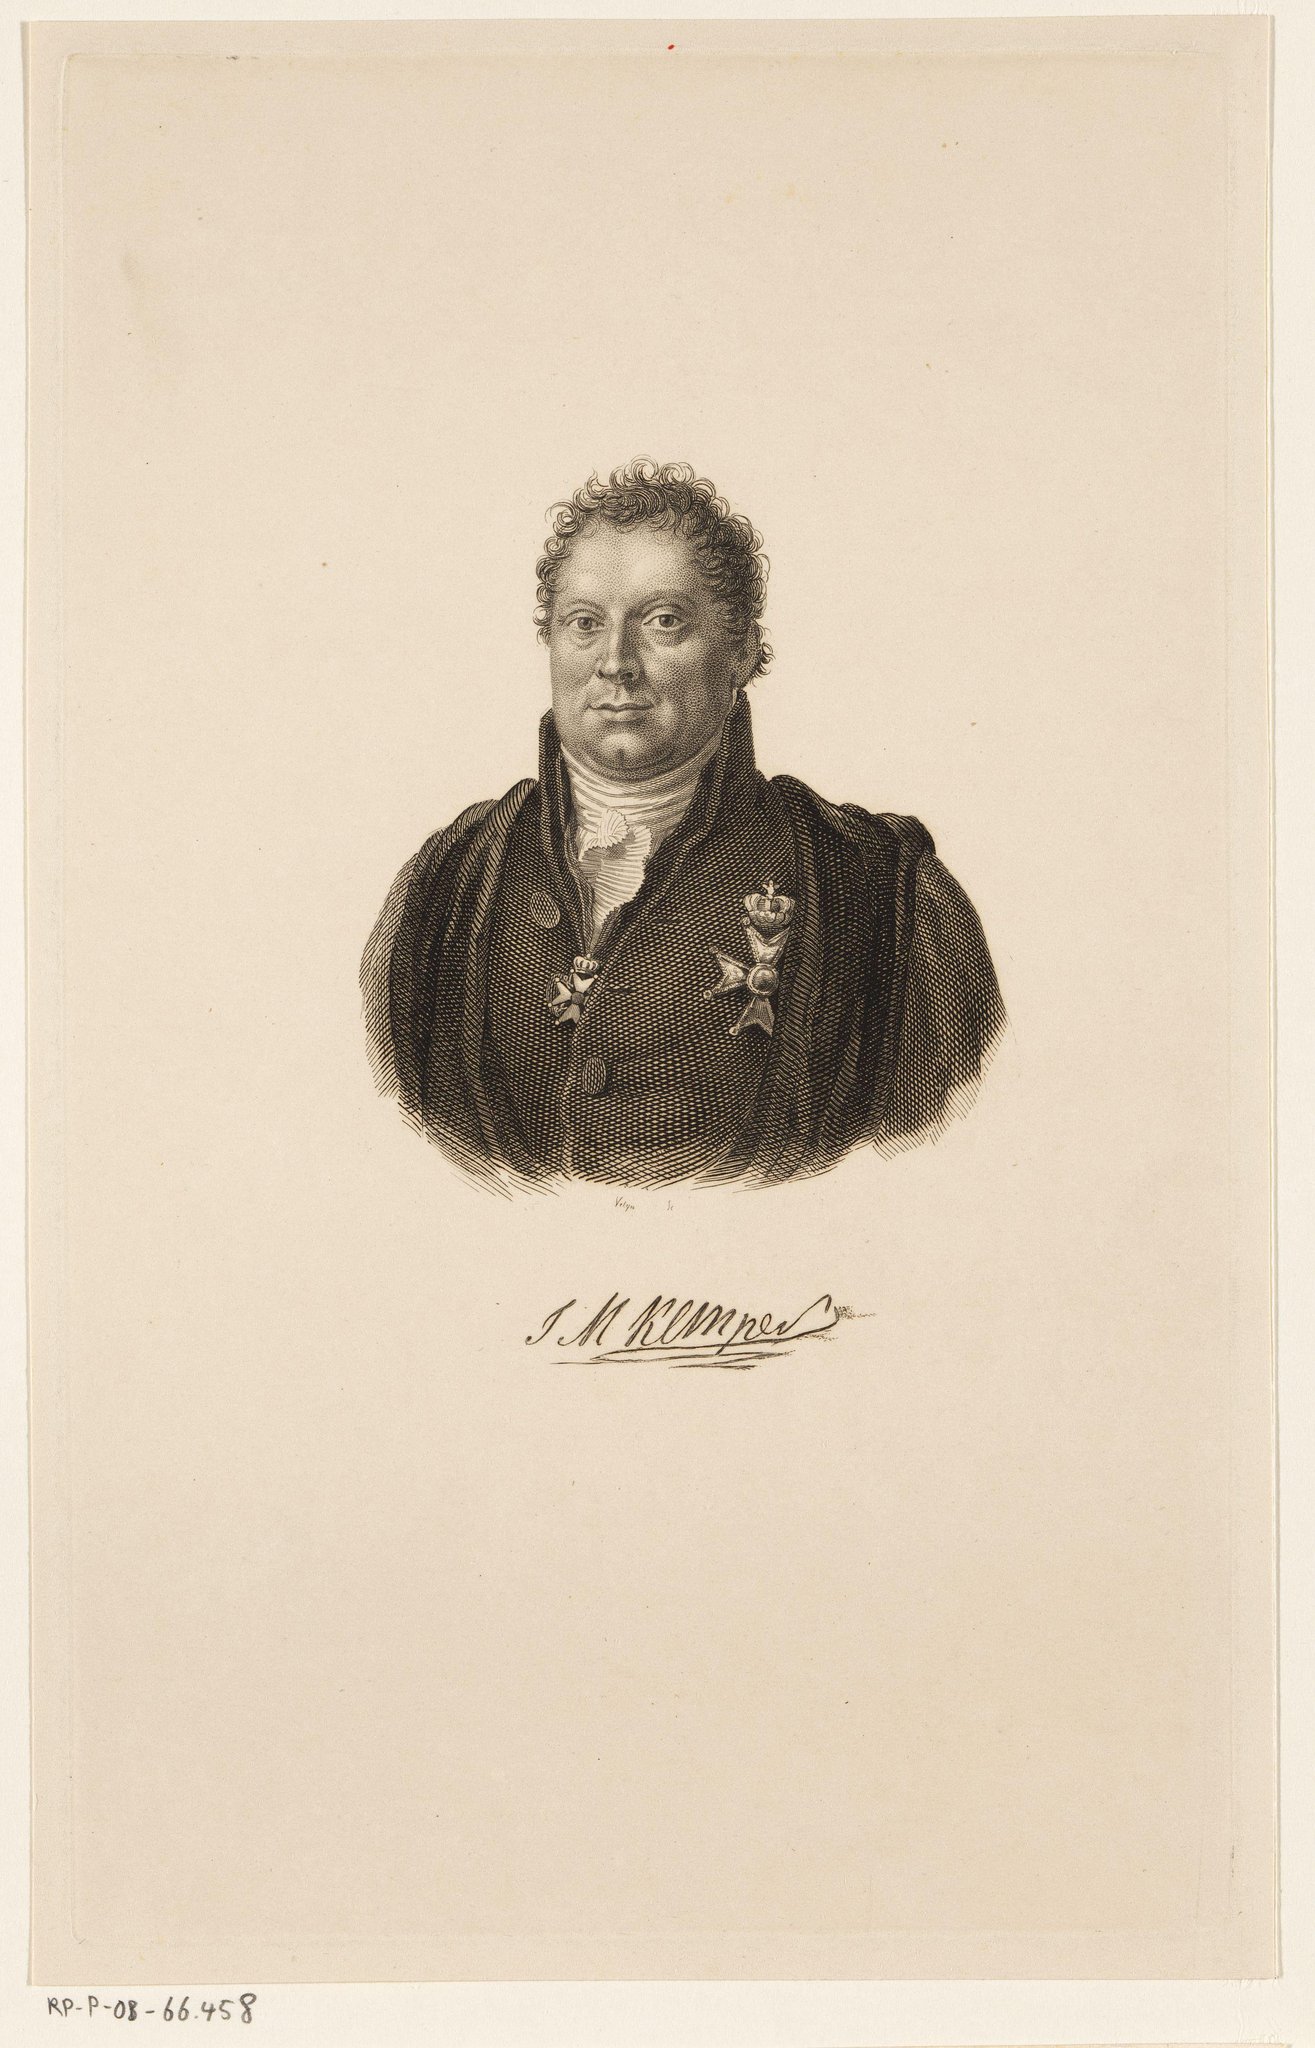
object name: print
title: Portret van Johan Melchior Kemper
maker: philippus velijn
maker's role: print maker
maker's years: 1787-1836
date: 1797-1836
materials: paper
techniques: engraving, etching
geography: netherlands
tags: amsterdam, leiden, jonkheer joan melchior kemper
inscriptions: collector's mark: Lugt 2228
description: Portret van de jurist en staatsman Johan Melchior Kemper.